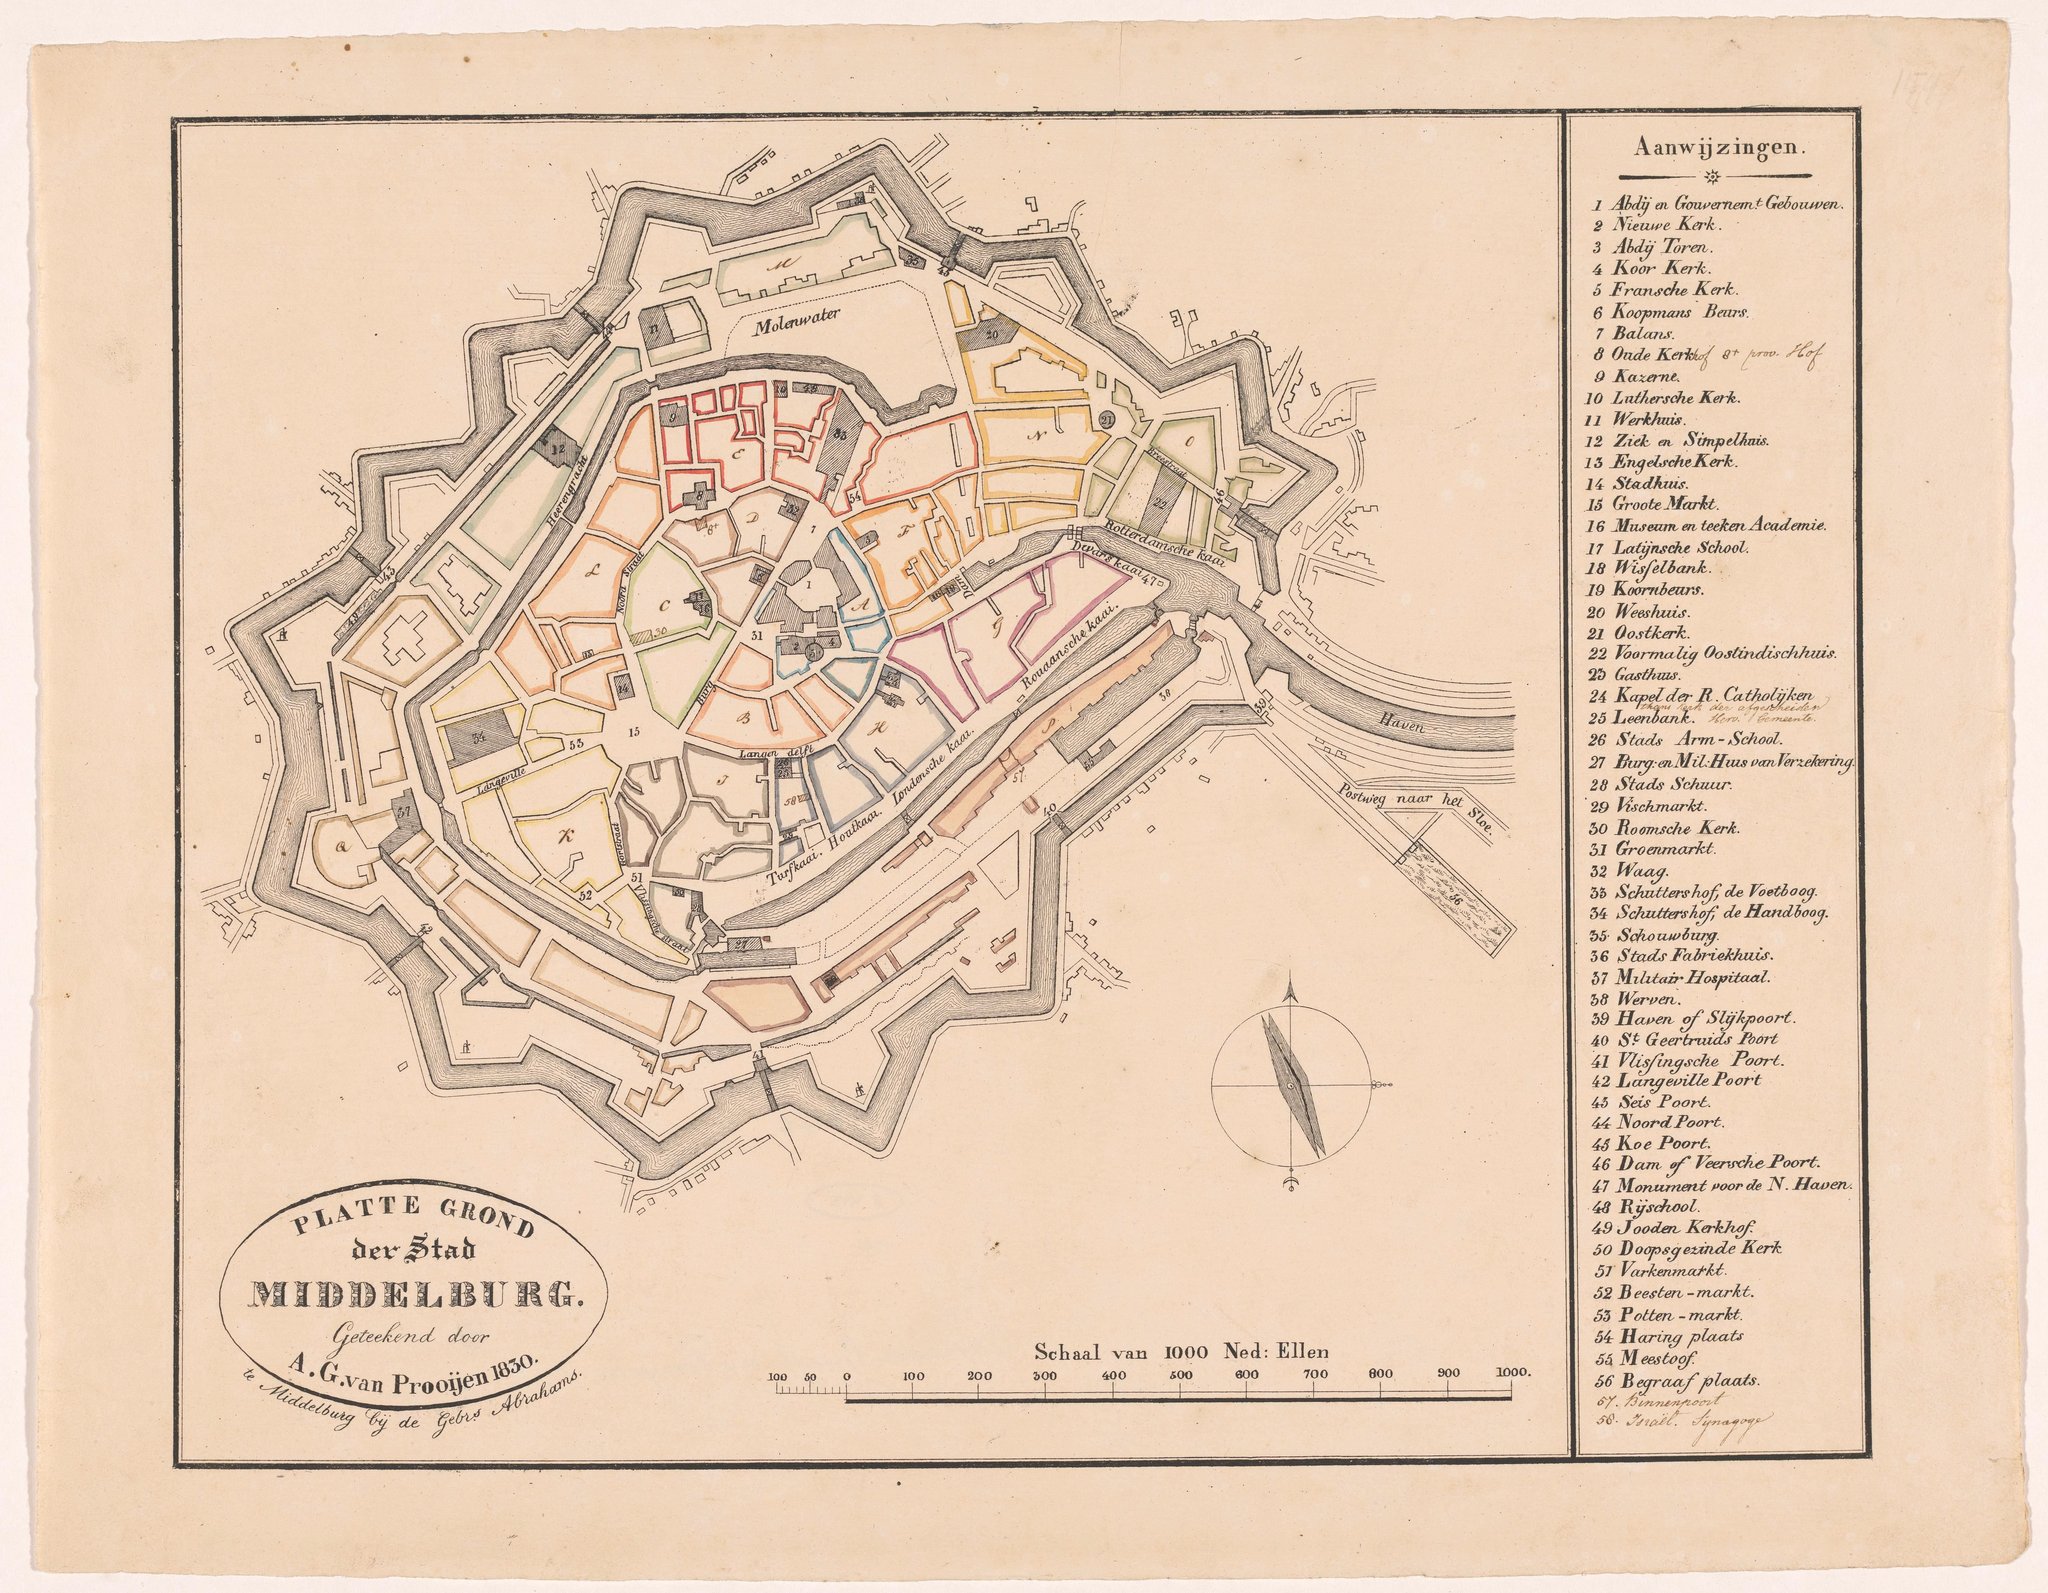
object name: print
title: Platte grond der stad Middelburg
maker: adriaan gerrit van prooijen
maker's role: print maker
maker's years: 1796-1854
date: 1830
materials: paper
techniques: etching, hand coloring, writing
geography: middelburg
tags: maps of cities, middelburg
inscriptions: collector's mark: Lugt 2760, collector's mark: Lugt 2228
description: Stadsplattegrond van Middelburg met schaalaanduiding, windroos en legenda.